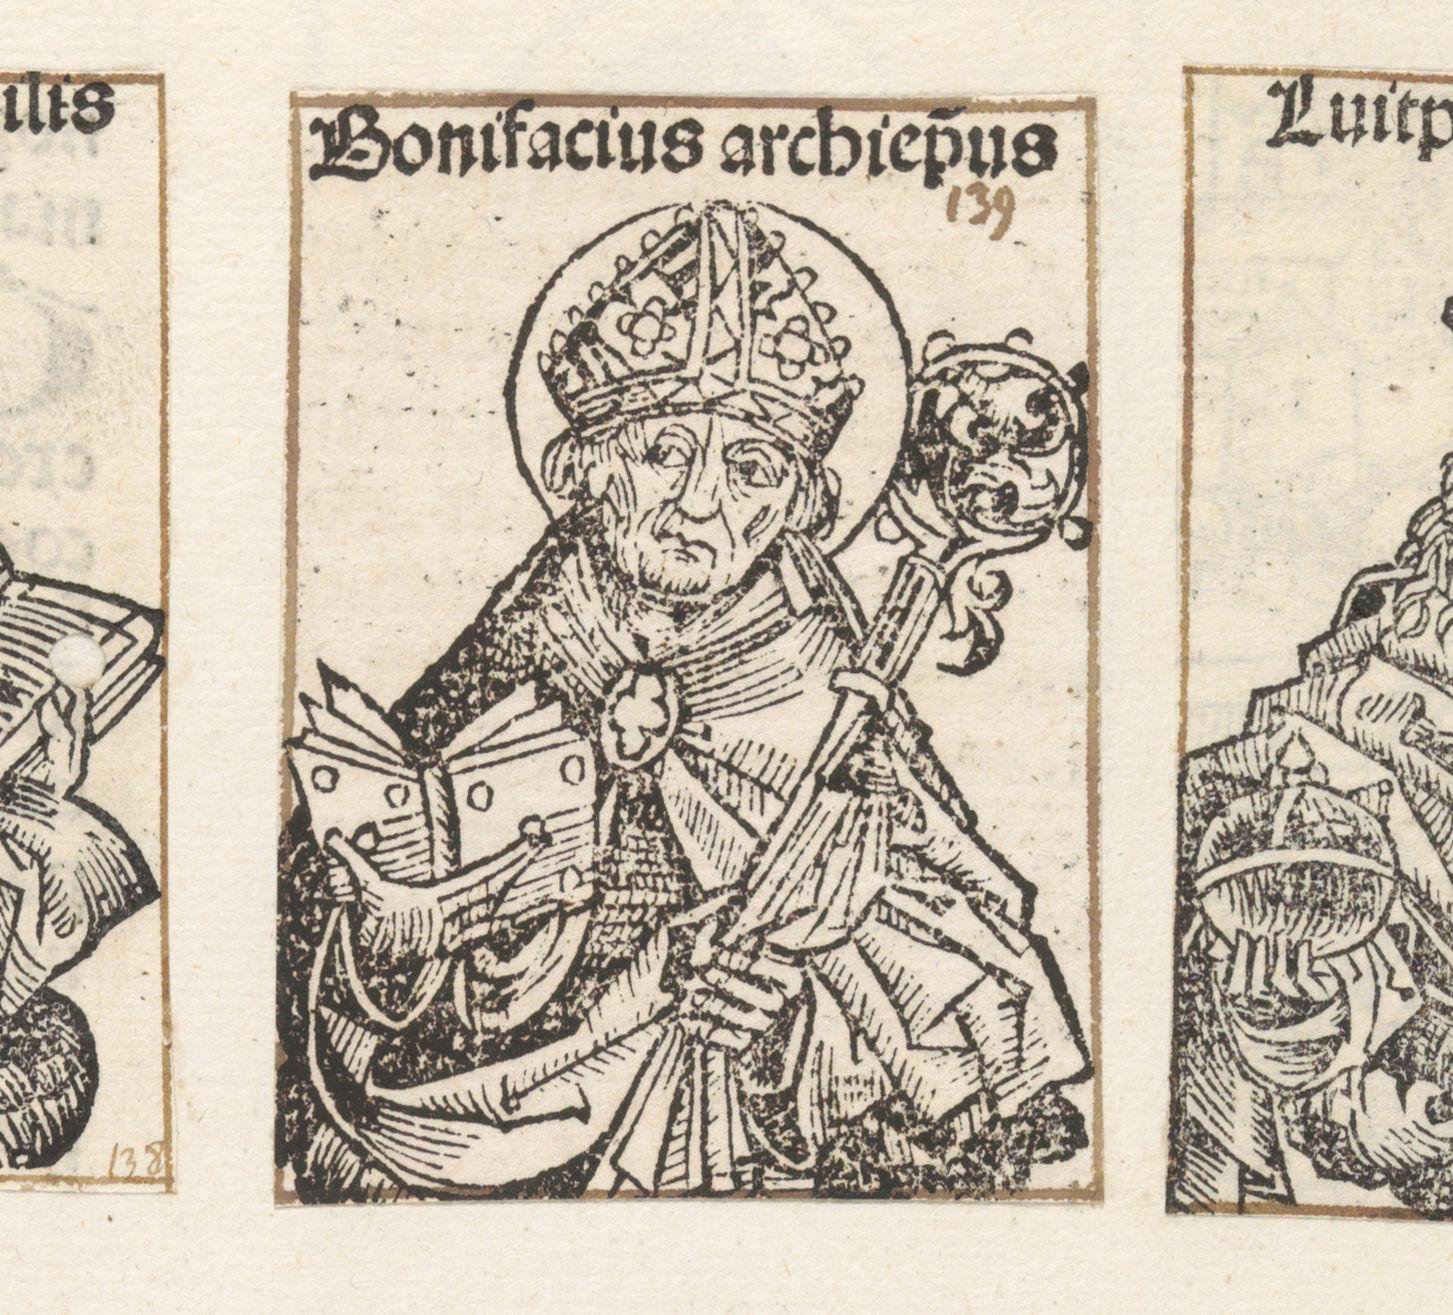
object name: book illustration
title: Bonifacius archiep[icopu]s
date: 1493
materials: paper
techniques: letterpress printing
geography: nuremberg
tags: archbishop, bishop, etc. (roman catholic), reading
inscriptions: inscription: ‘139’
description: De houtsnede wordt herhaaldelijk gebruikt als boekillustratie in de Liber Chronicarum (of Neurenbergkroniek) van Hartmann Schedel, verschenen in het Latijn en Duits in 1493. Zie de Latijnse uitgave, folio 161v.